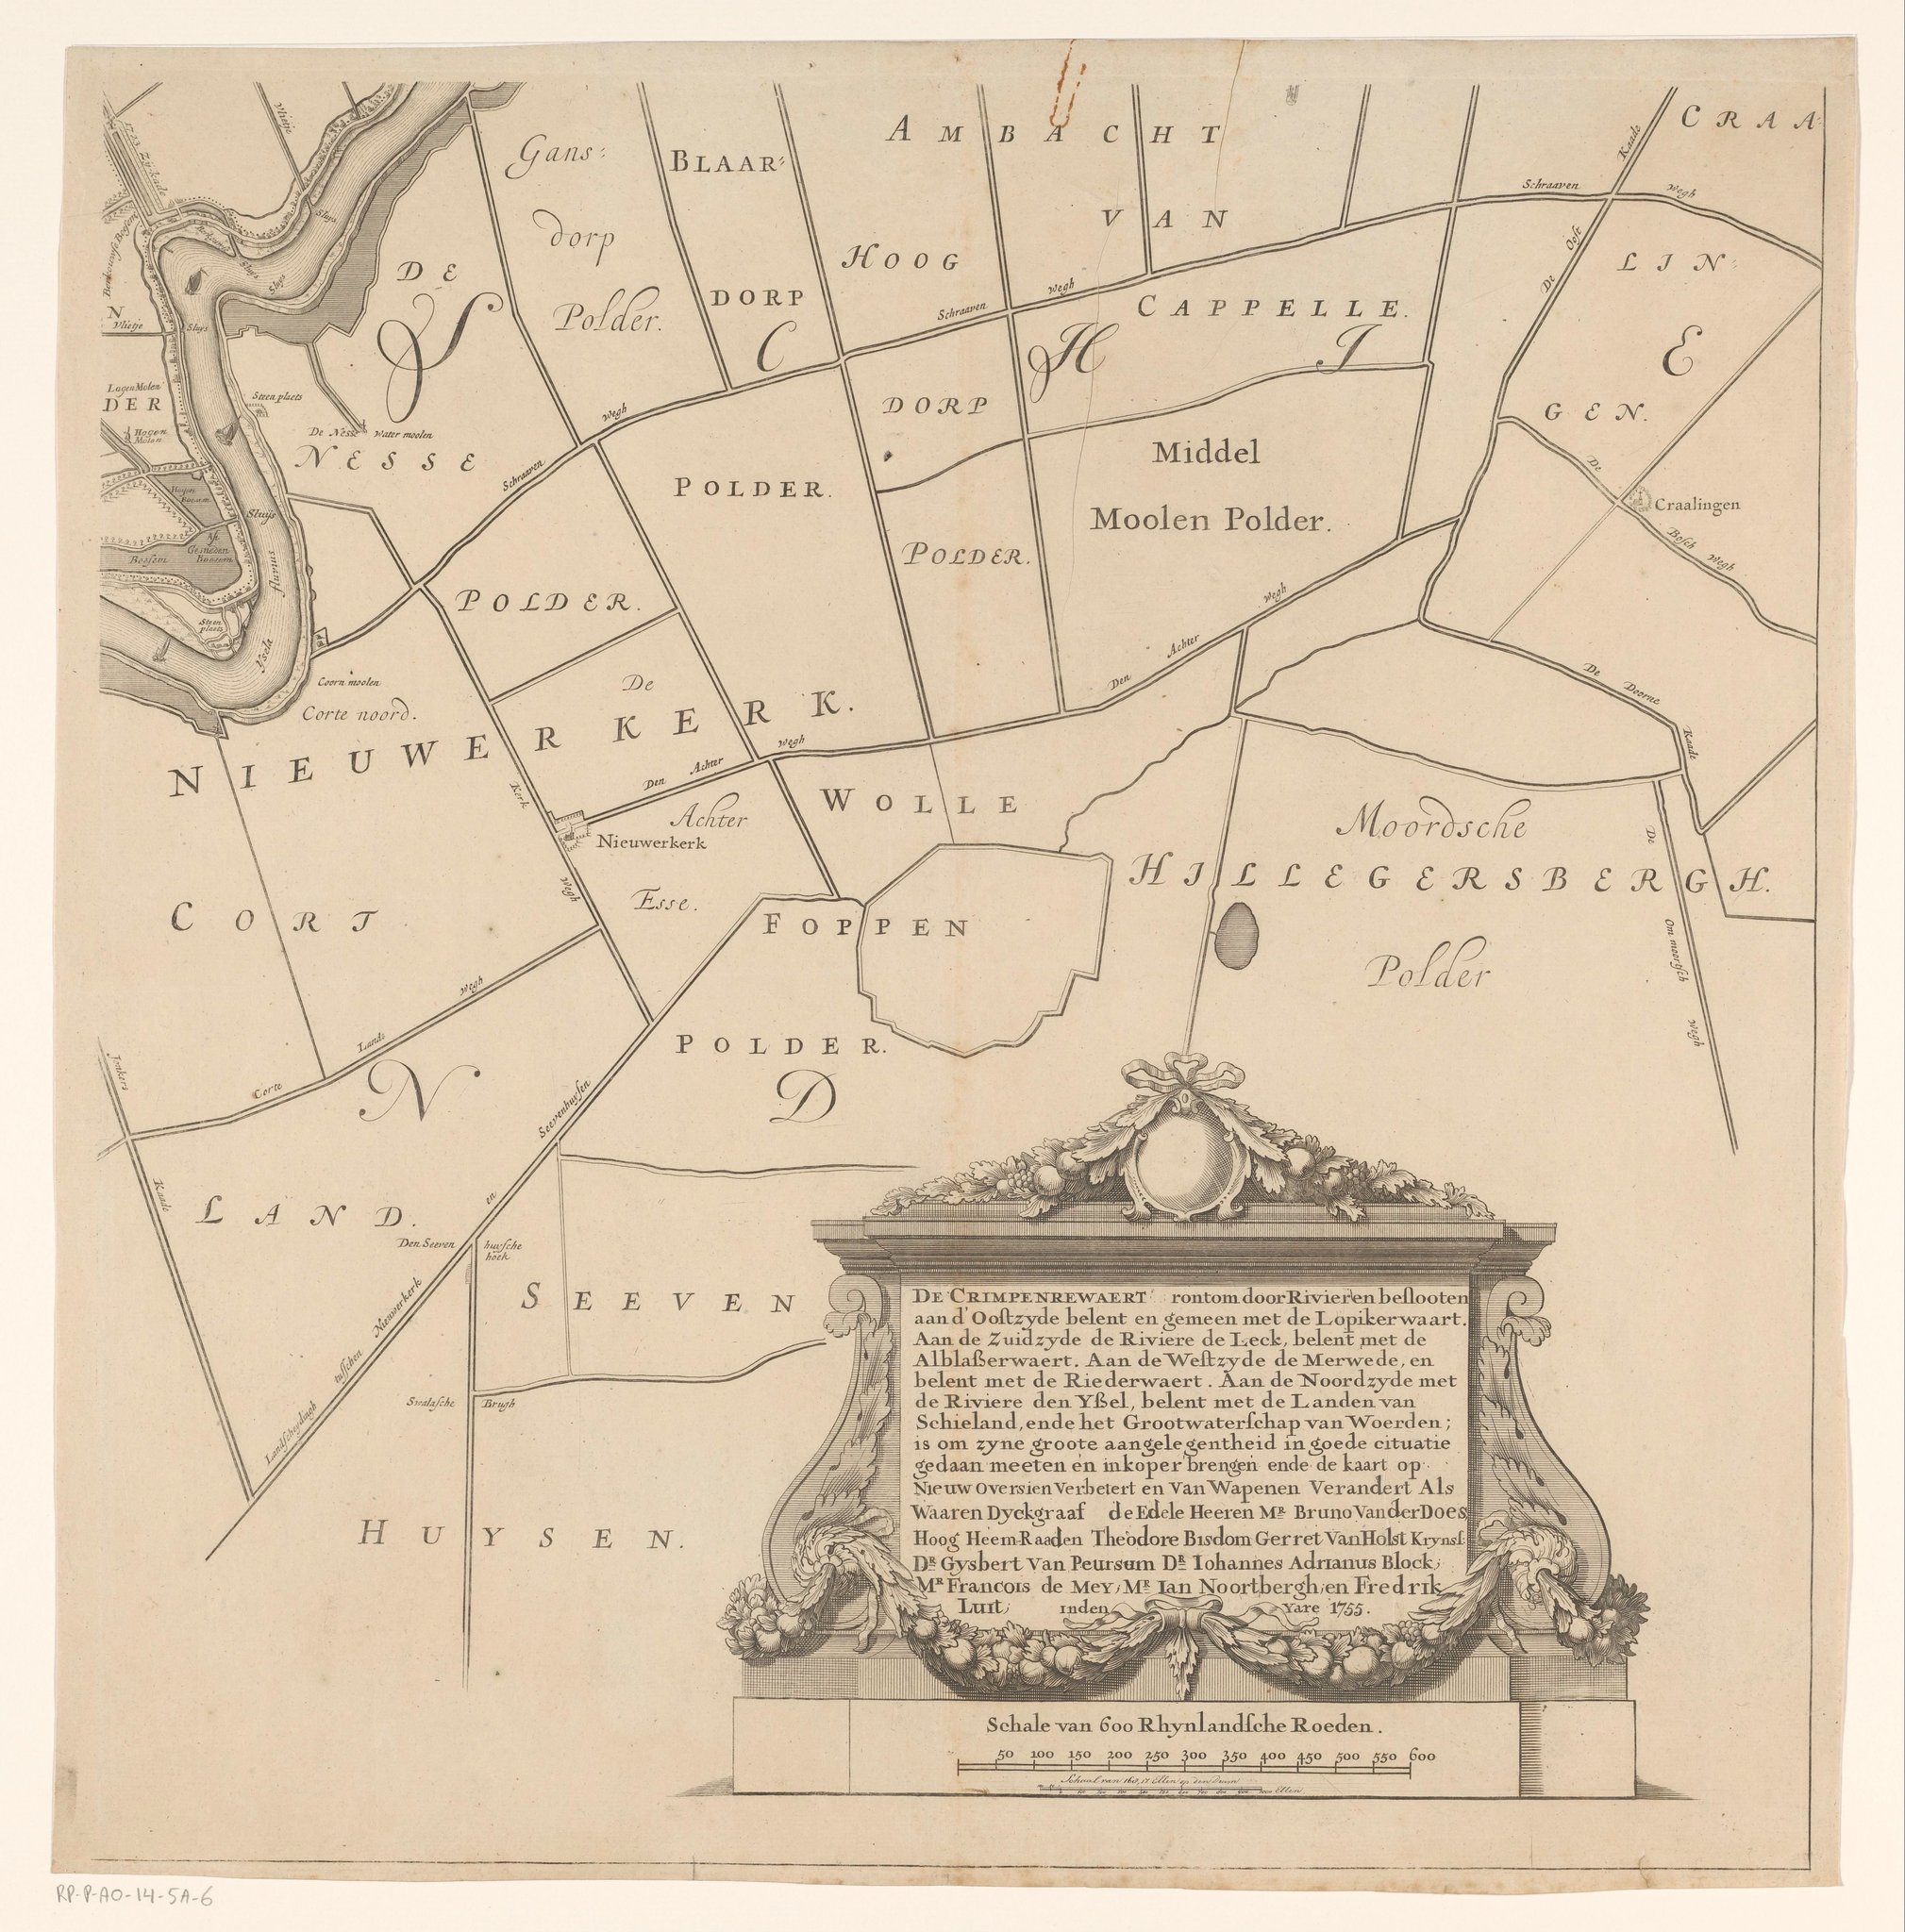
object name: print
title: Kaart van het Hoogheemraadschap van de Krimpenerwaard (zesde deel van kaart)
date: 1683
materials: ink, paper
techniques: engraving, etching, pen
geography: amsterdam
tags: maps of separate countries or regions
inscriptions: inscription: ‘Schaal van 168, 17 ellen op den duim’, collector's mark: Lugt 19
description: Zesde deel van de kaart van de zesde druk van 'Het Hooge Heemraadschap van de Crimpenre Waard', een wandkaart (bestaande uit een zesdelige kaart en een wapenrand) van het Hoogheemraadschap van de Krimpenerwaard.